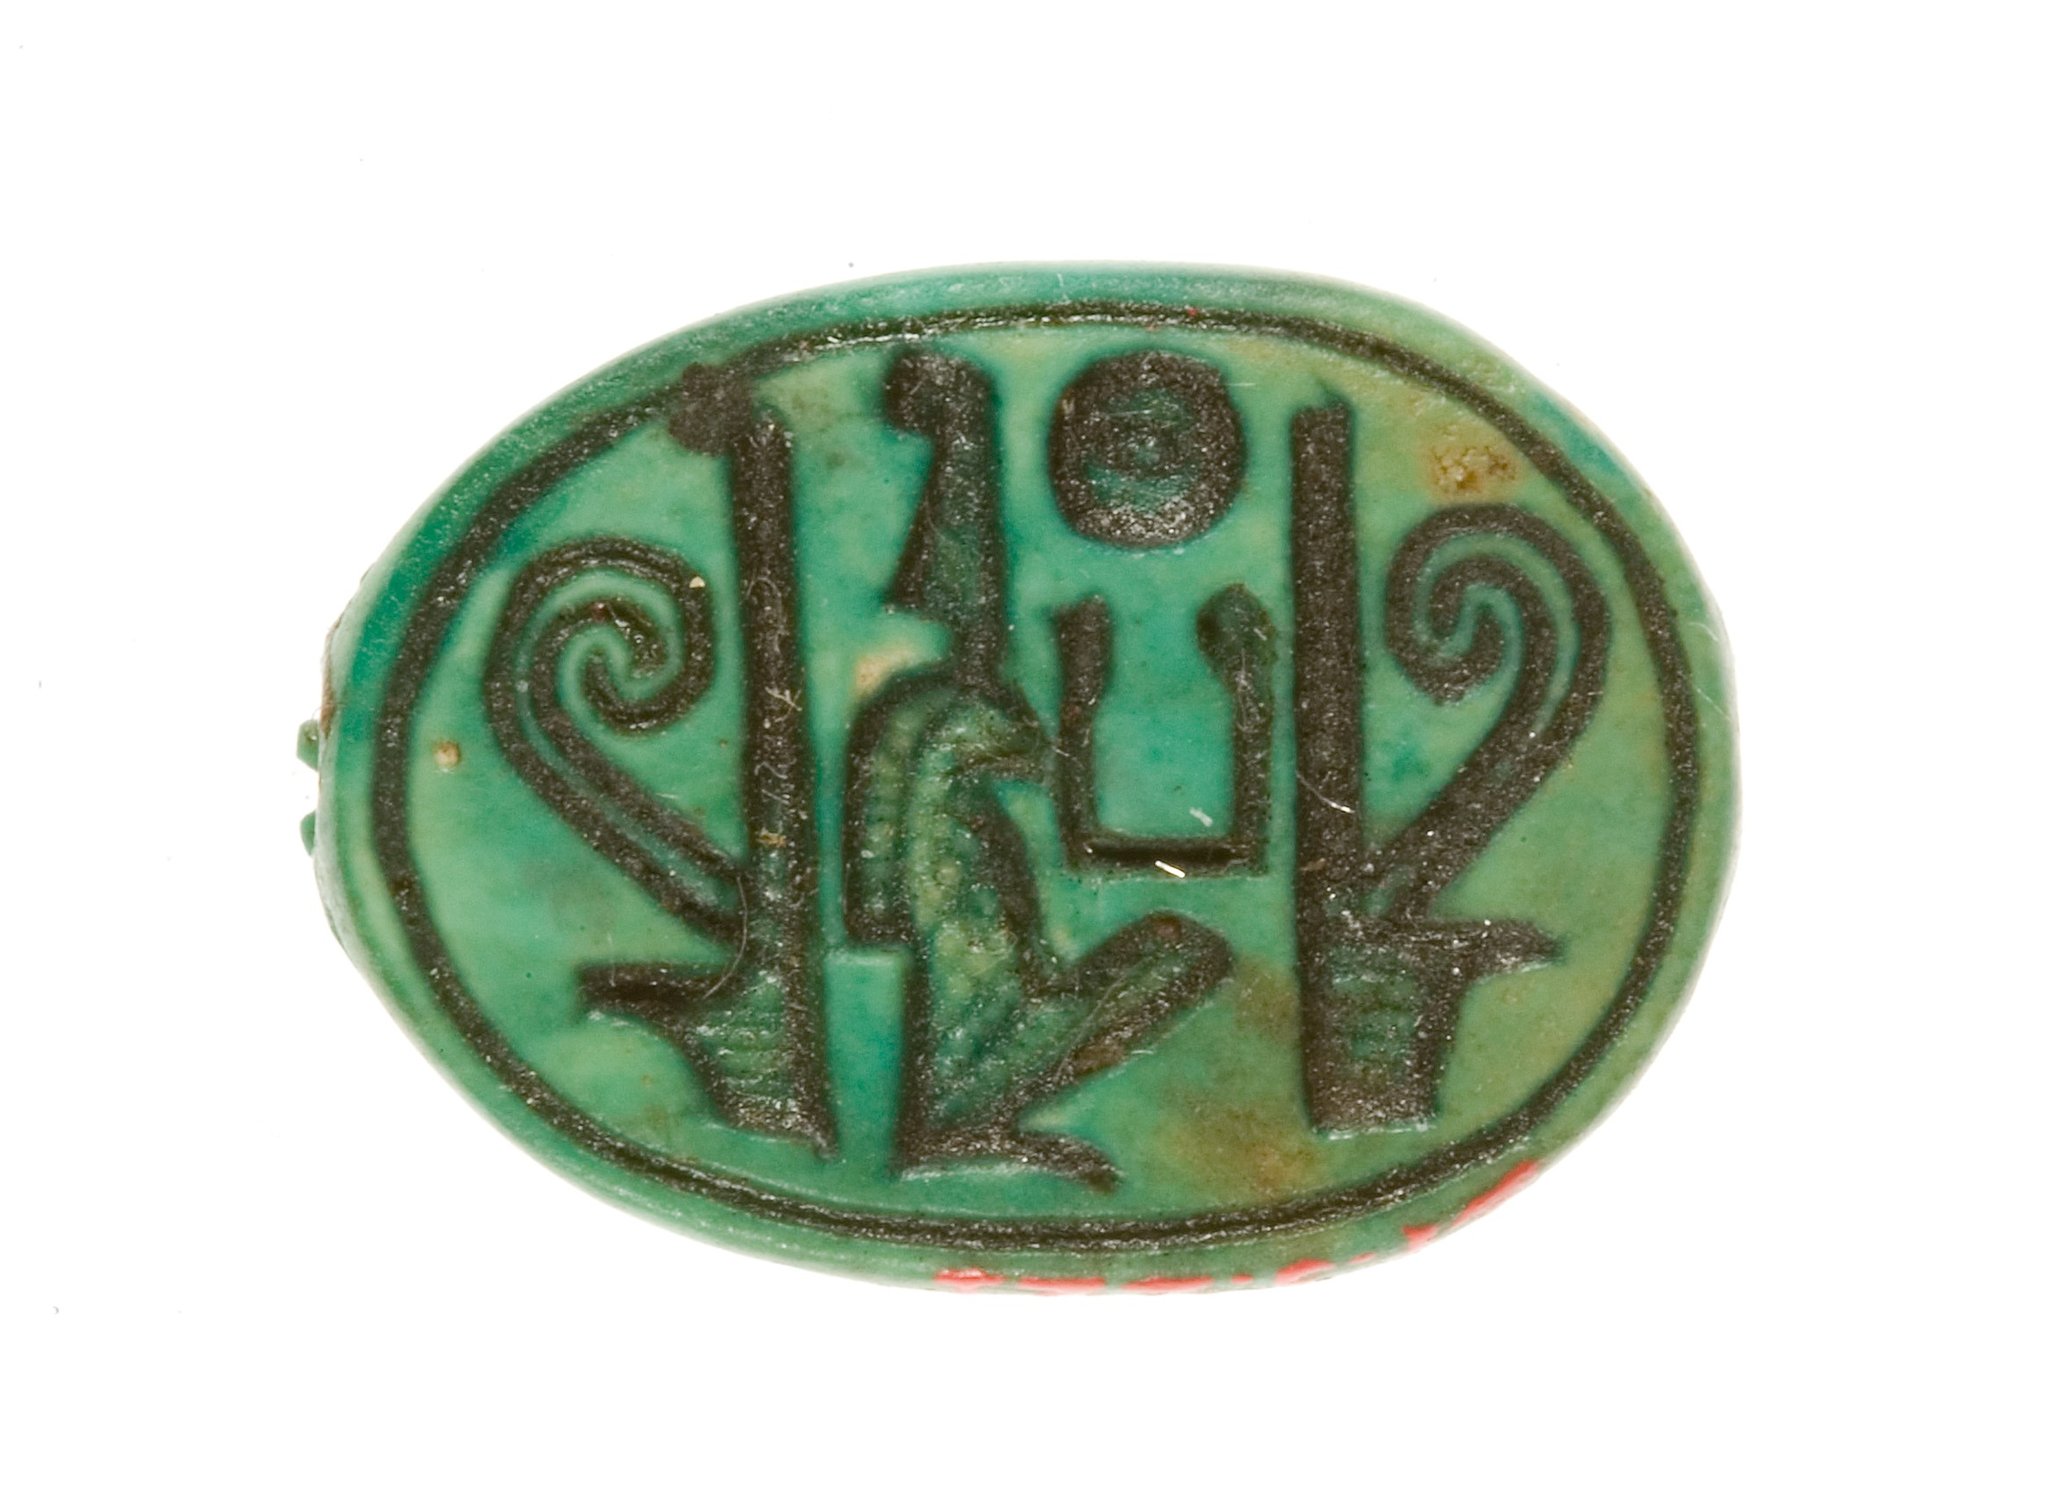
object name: scarab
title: Scarab Inscribed with the Name Maatkare (Hatshepsut) Flanked by Two Red Crowns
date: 1479-1458 BCE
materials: stone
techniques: glazing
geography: egypt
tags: hieroglyphs,scarabs